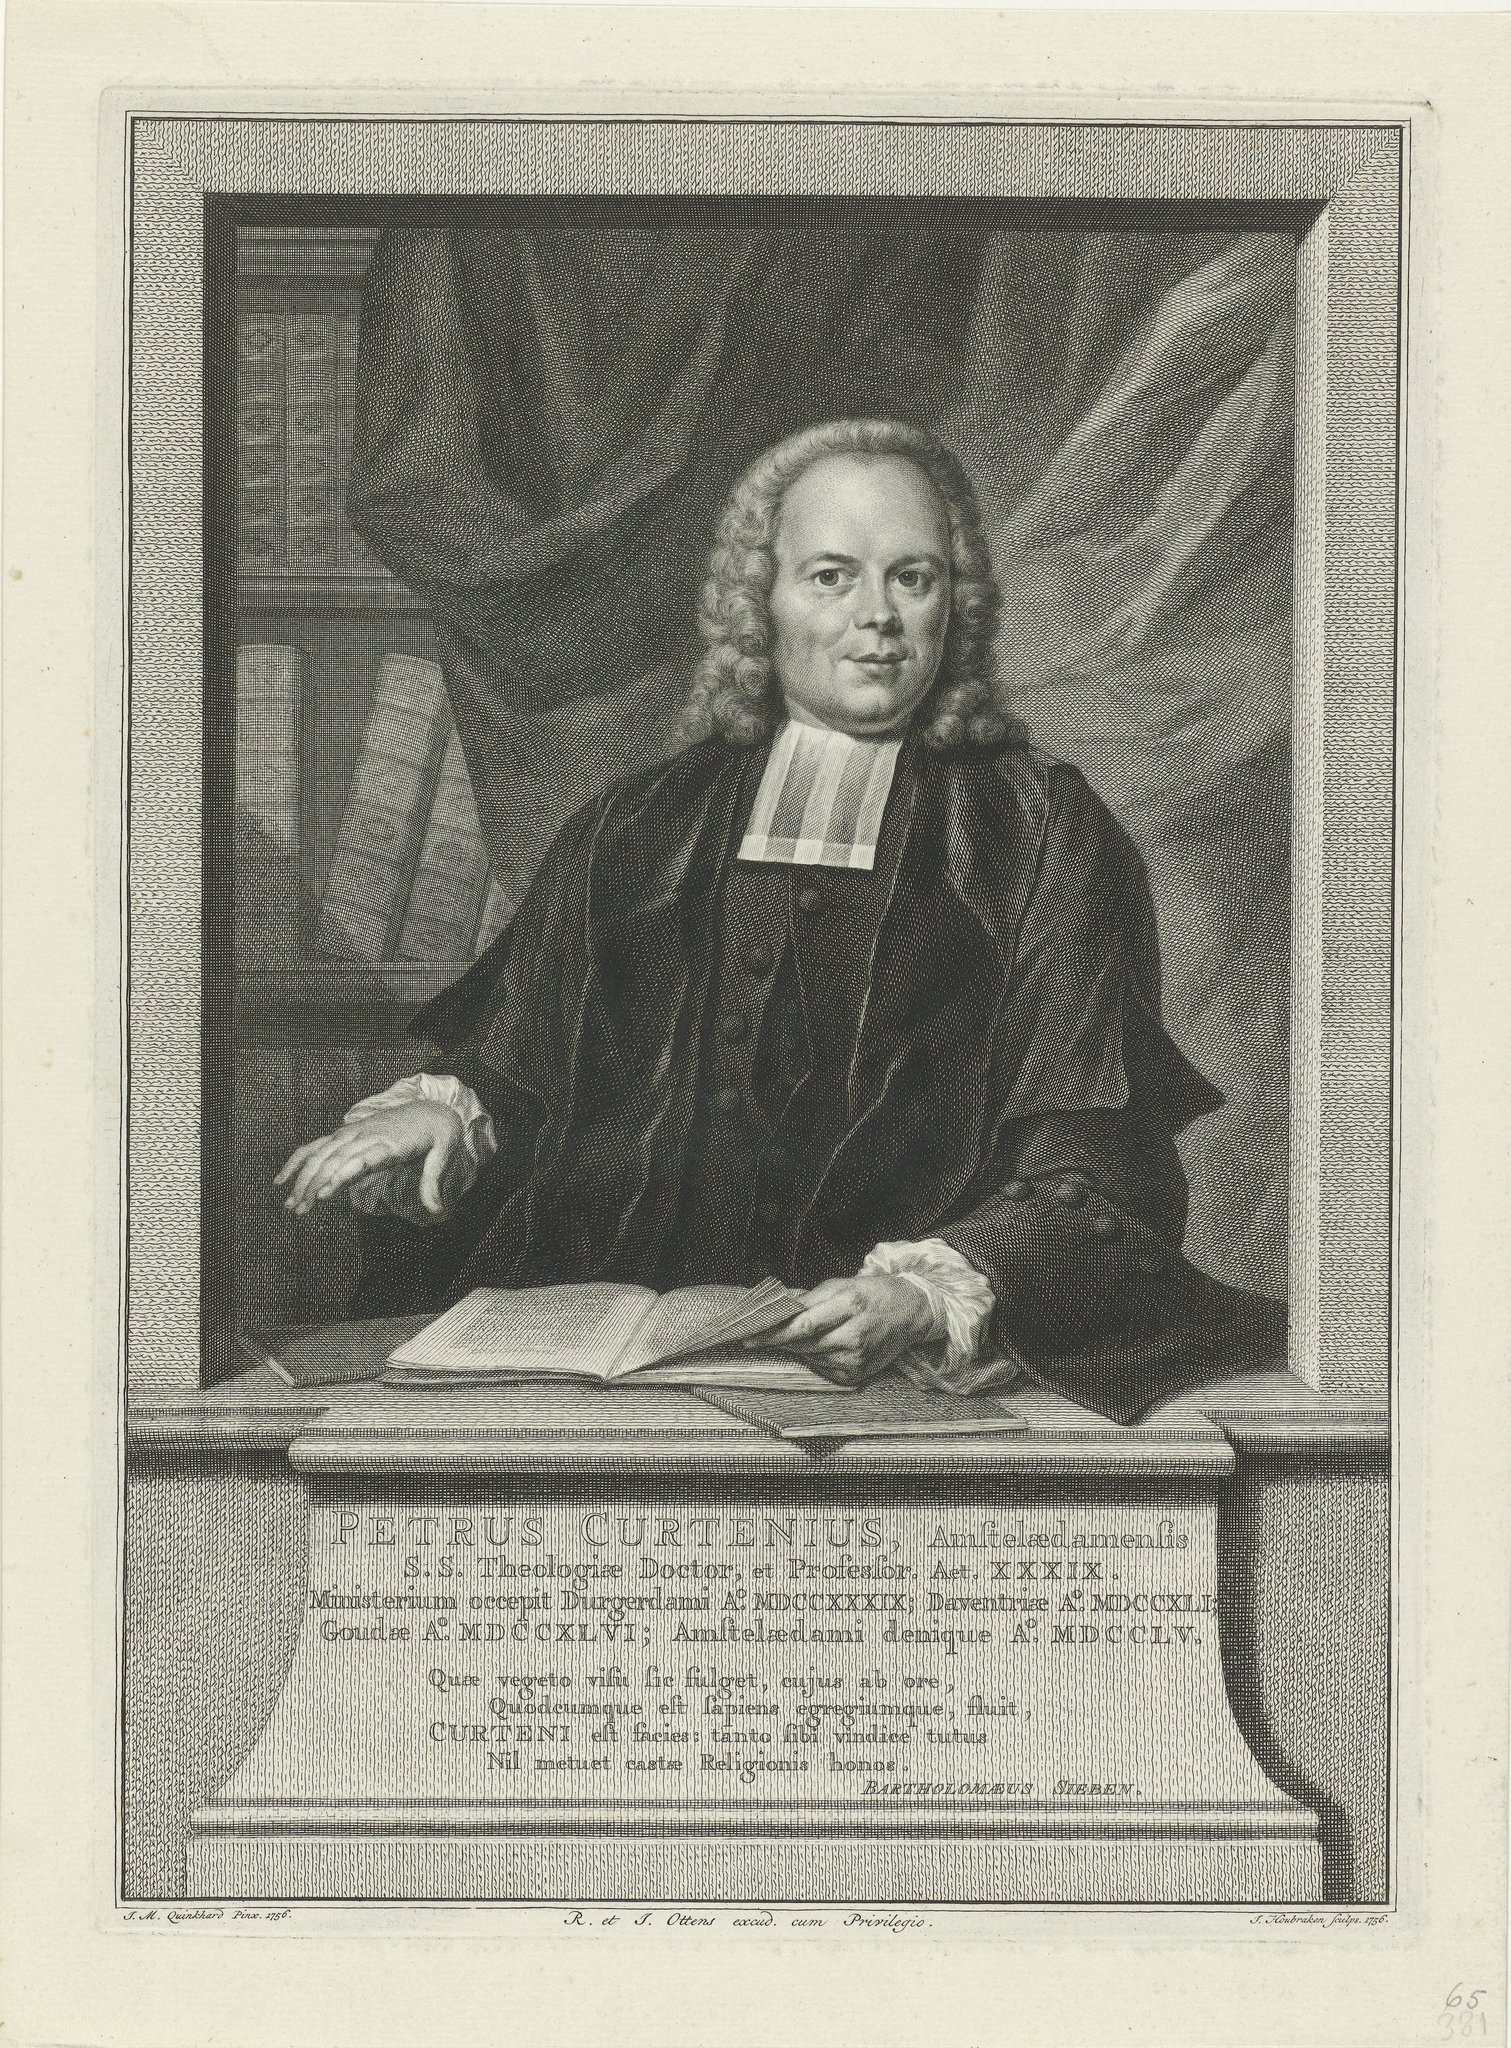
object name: print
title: Petrus Curtenius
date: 1756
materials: paper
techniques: engraving, etching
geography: amsterdam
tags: amsterdam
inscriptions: collector's mark: Lugt 240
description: Portret ten halven lijve van Petrus Curtenius op 39-jarige leeftijd voor een gordijn en een boekenkast. Voor hem een plint waarop enkele geschriften. Onder het portret zijn naam en gegevens in vier regels in het Latijn en daaronder een vierregelig vers in het Latijn.